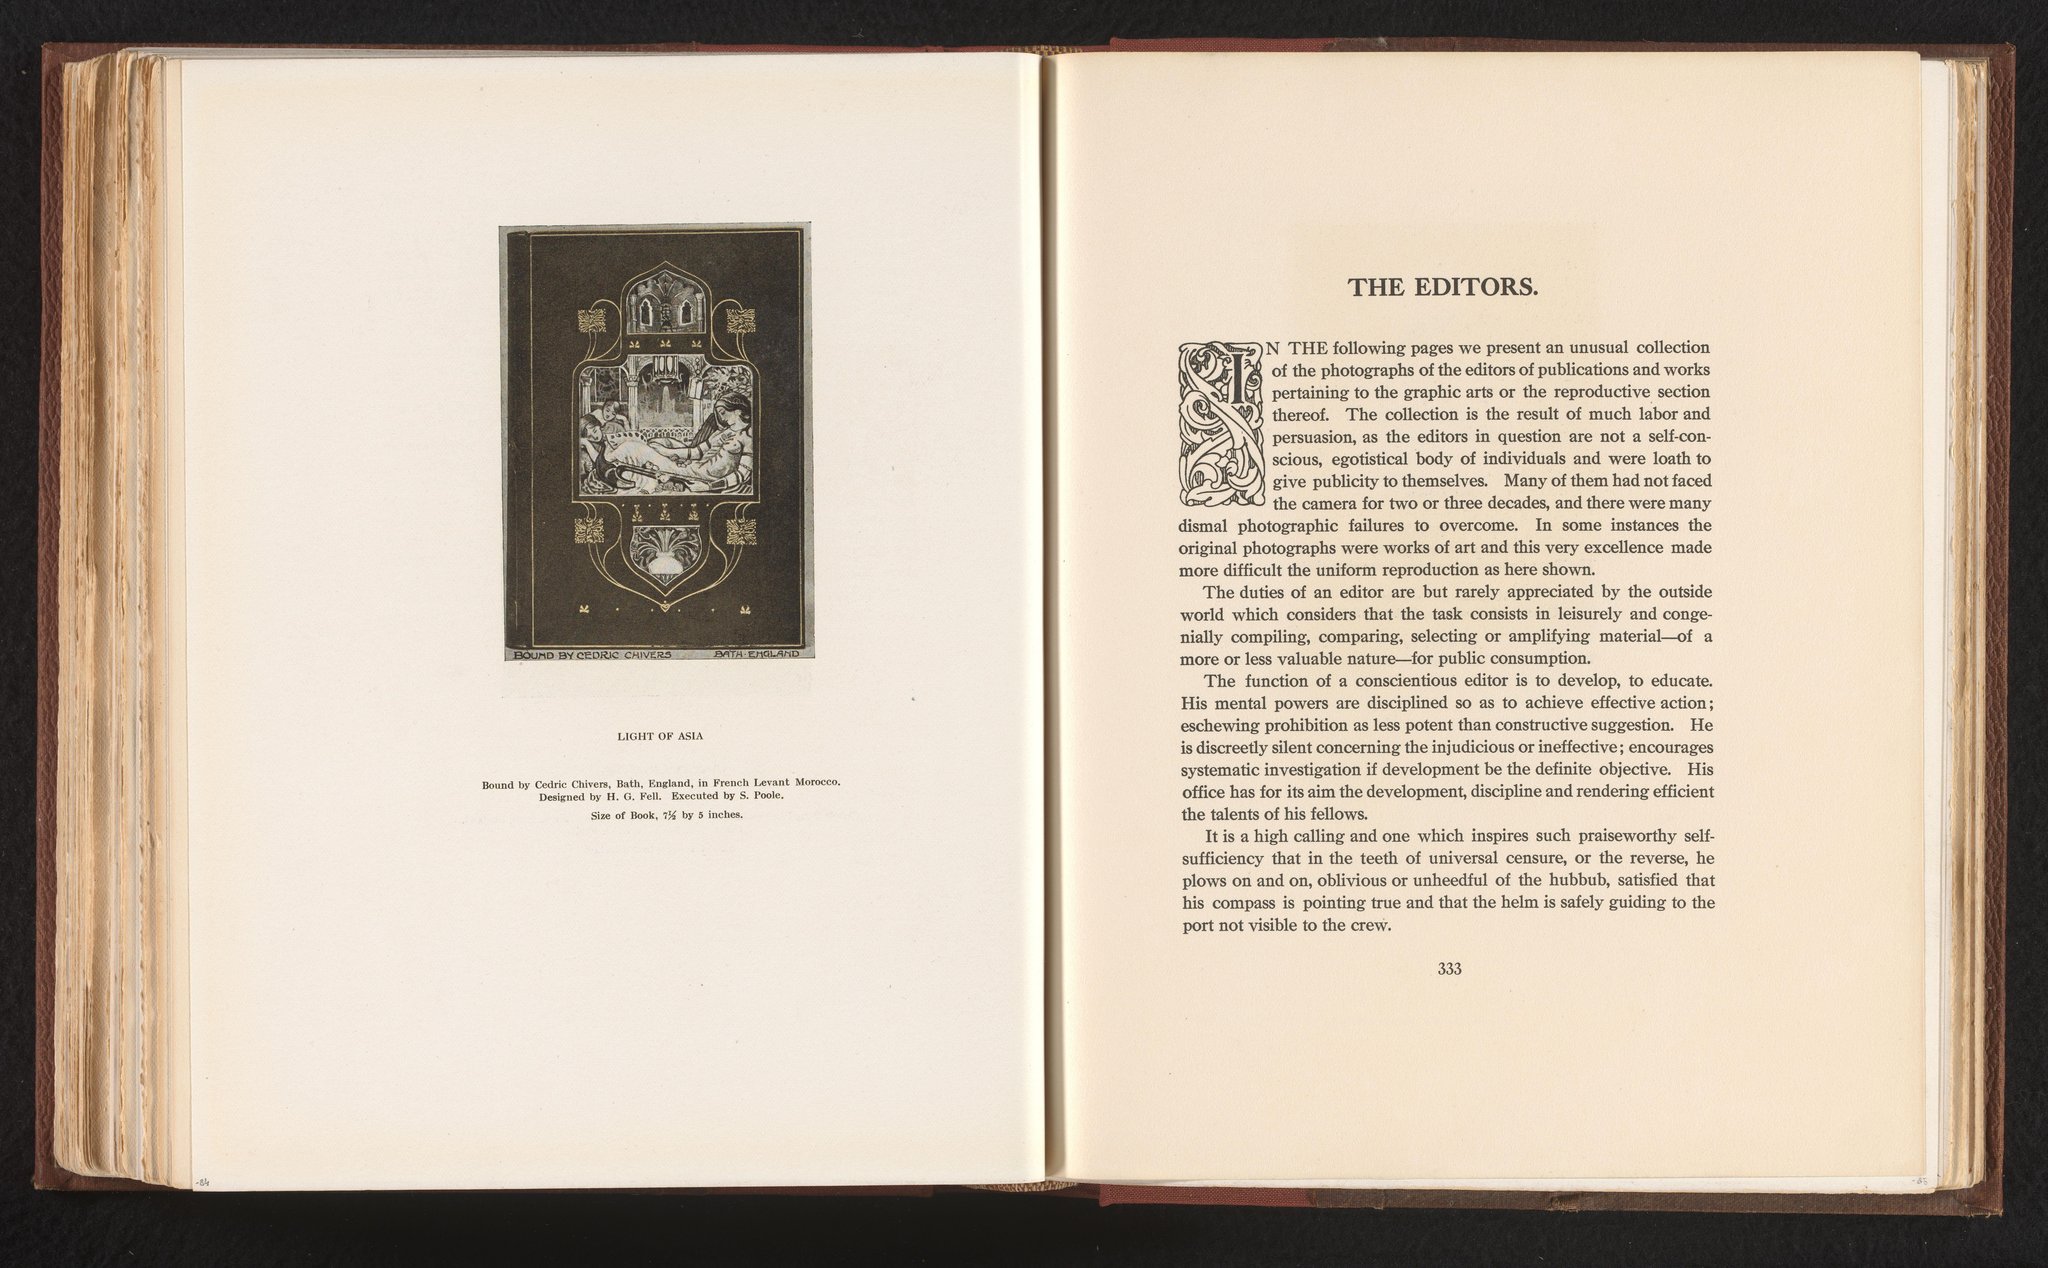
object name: reproduction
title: Troye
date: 1904-1909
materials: paper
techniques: color autotype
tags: book-cover, binding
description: Prent op tweede ongenummerde pagina na pagina 330.